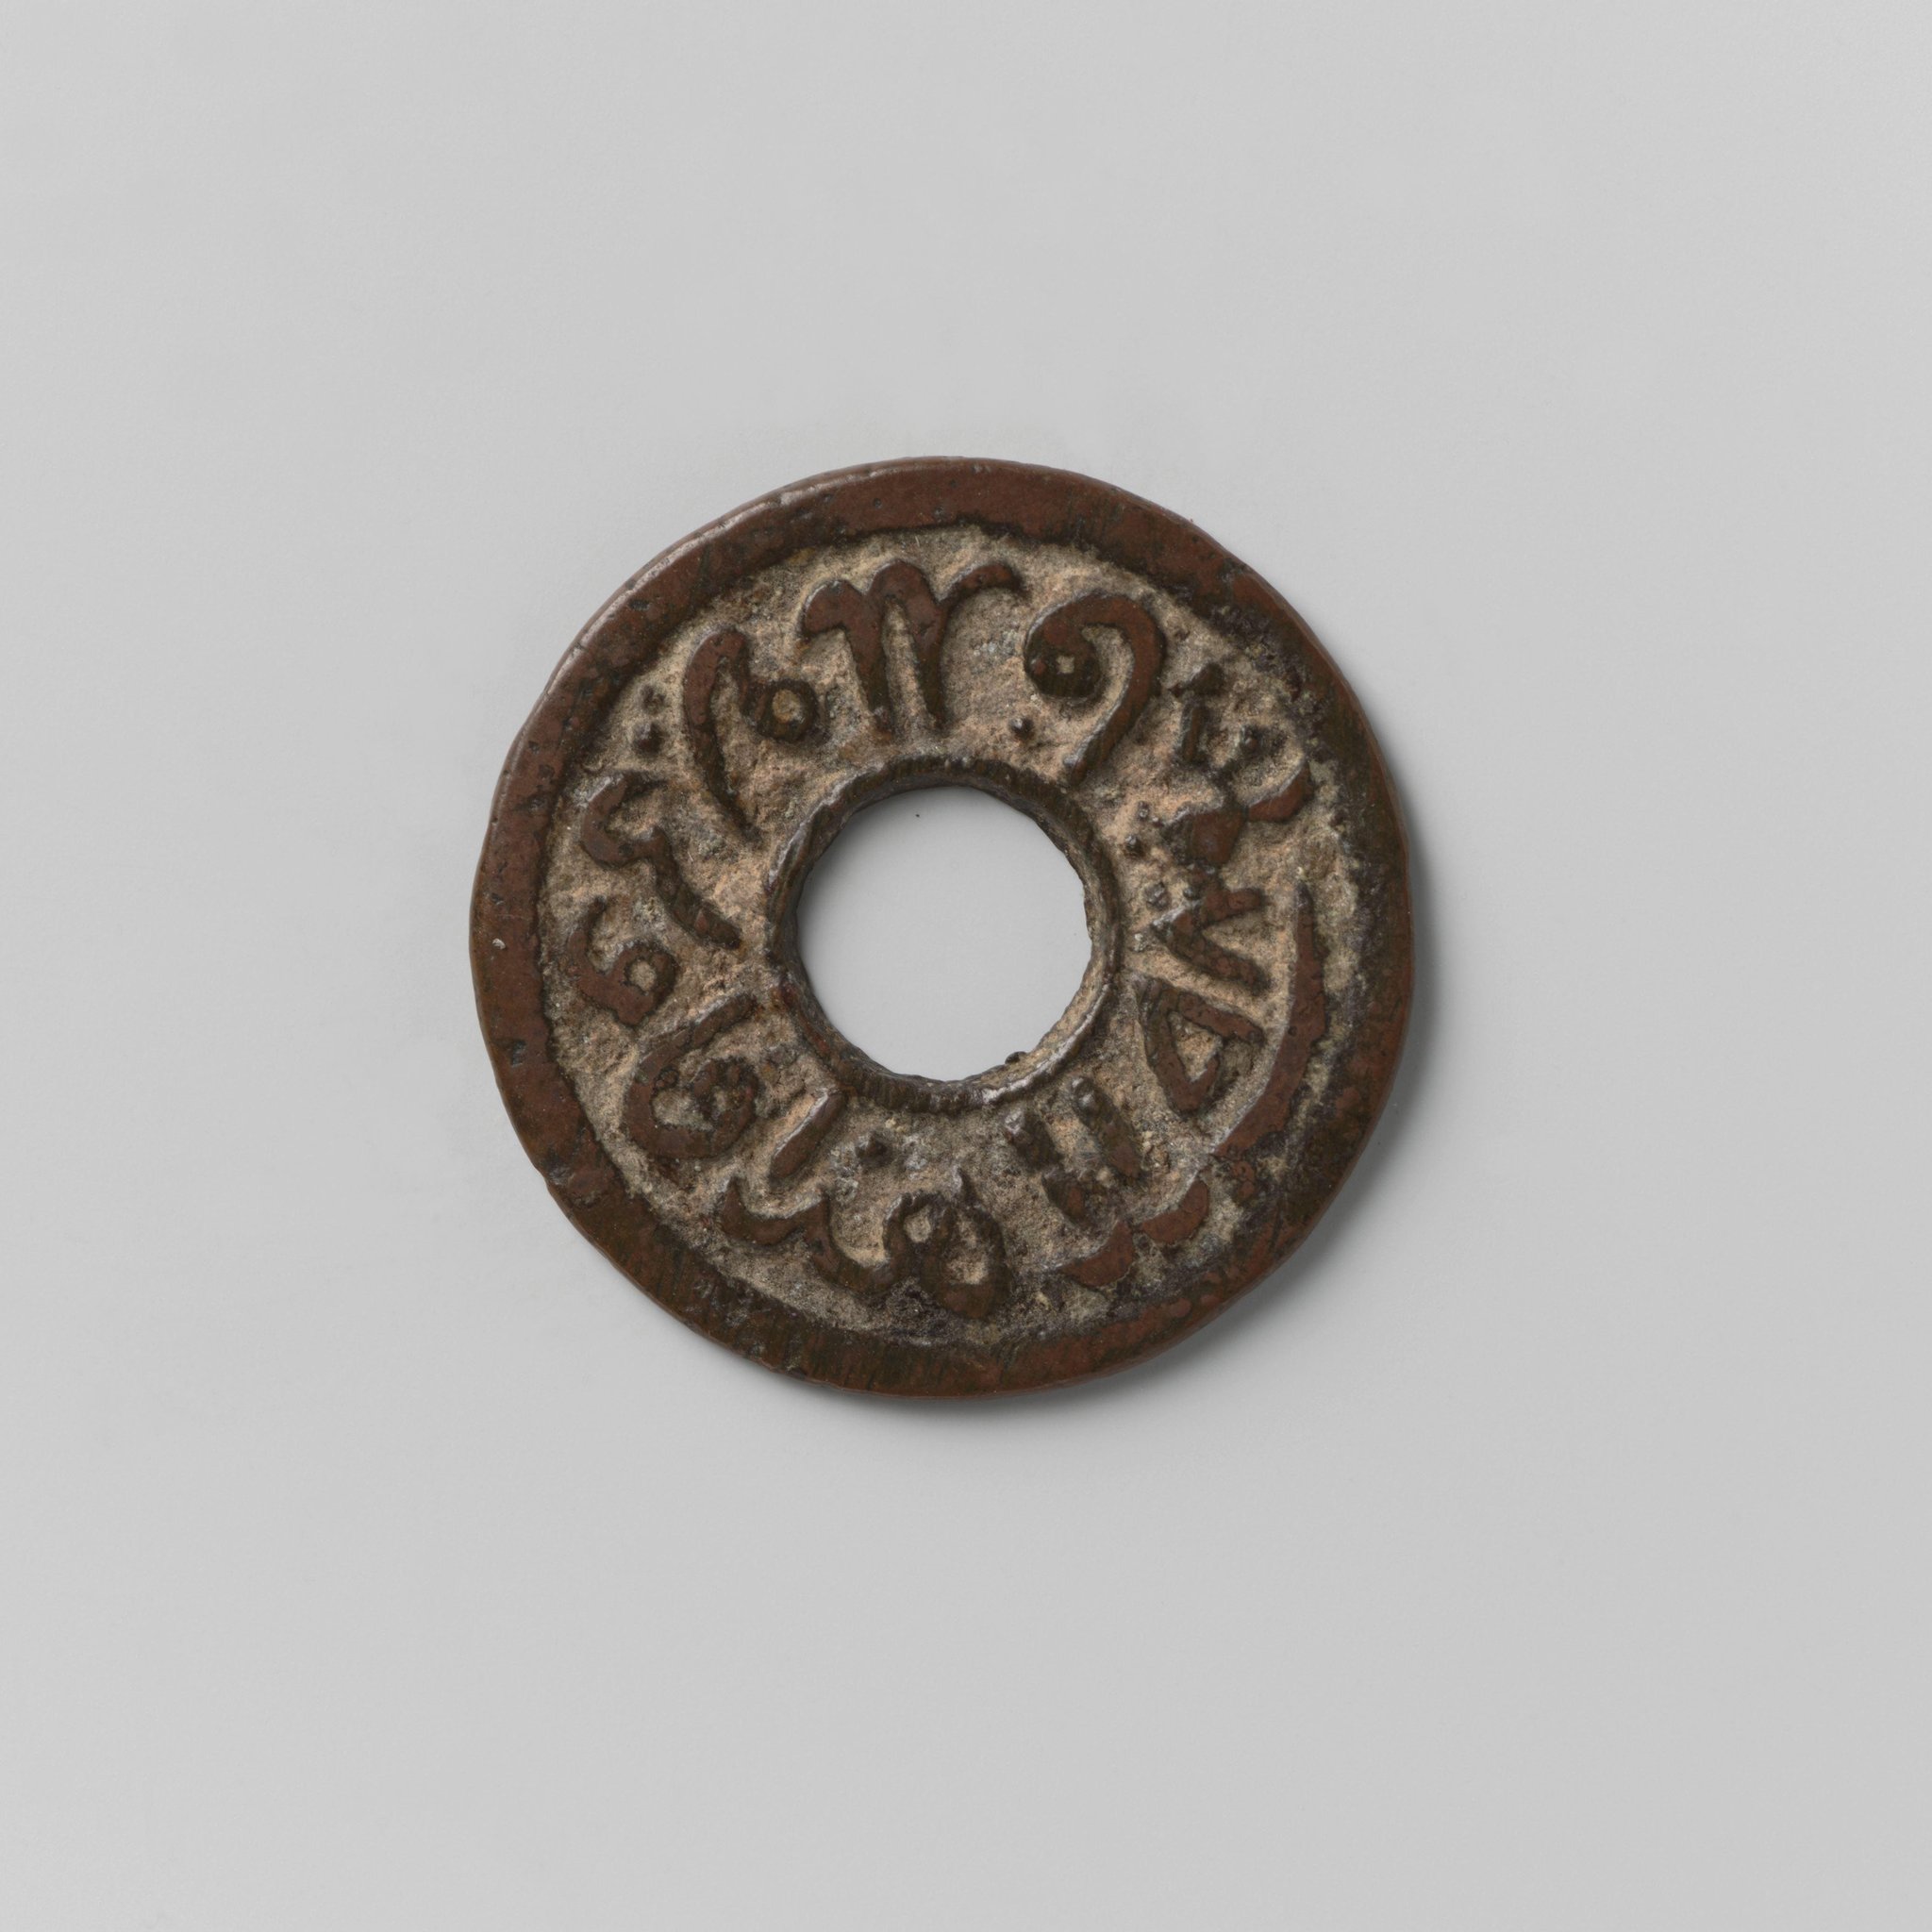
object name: coin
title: Palembang, Sumatra, sultan Mohammed Beha ed-din, pitji, A.H. 1198 (1784)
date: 1784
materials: tin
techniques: striking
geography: palembang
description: Tinnen munt. Voorzijde: omschrift in Arabische lettertekens, waartussen jaartal in Islamitische jaartelling. Keerzijde, glad. In het midden rond gat.